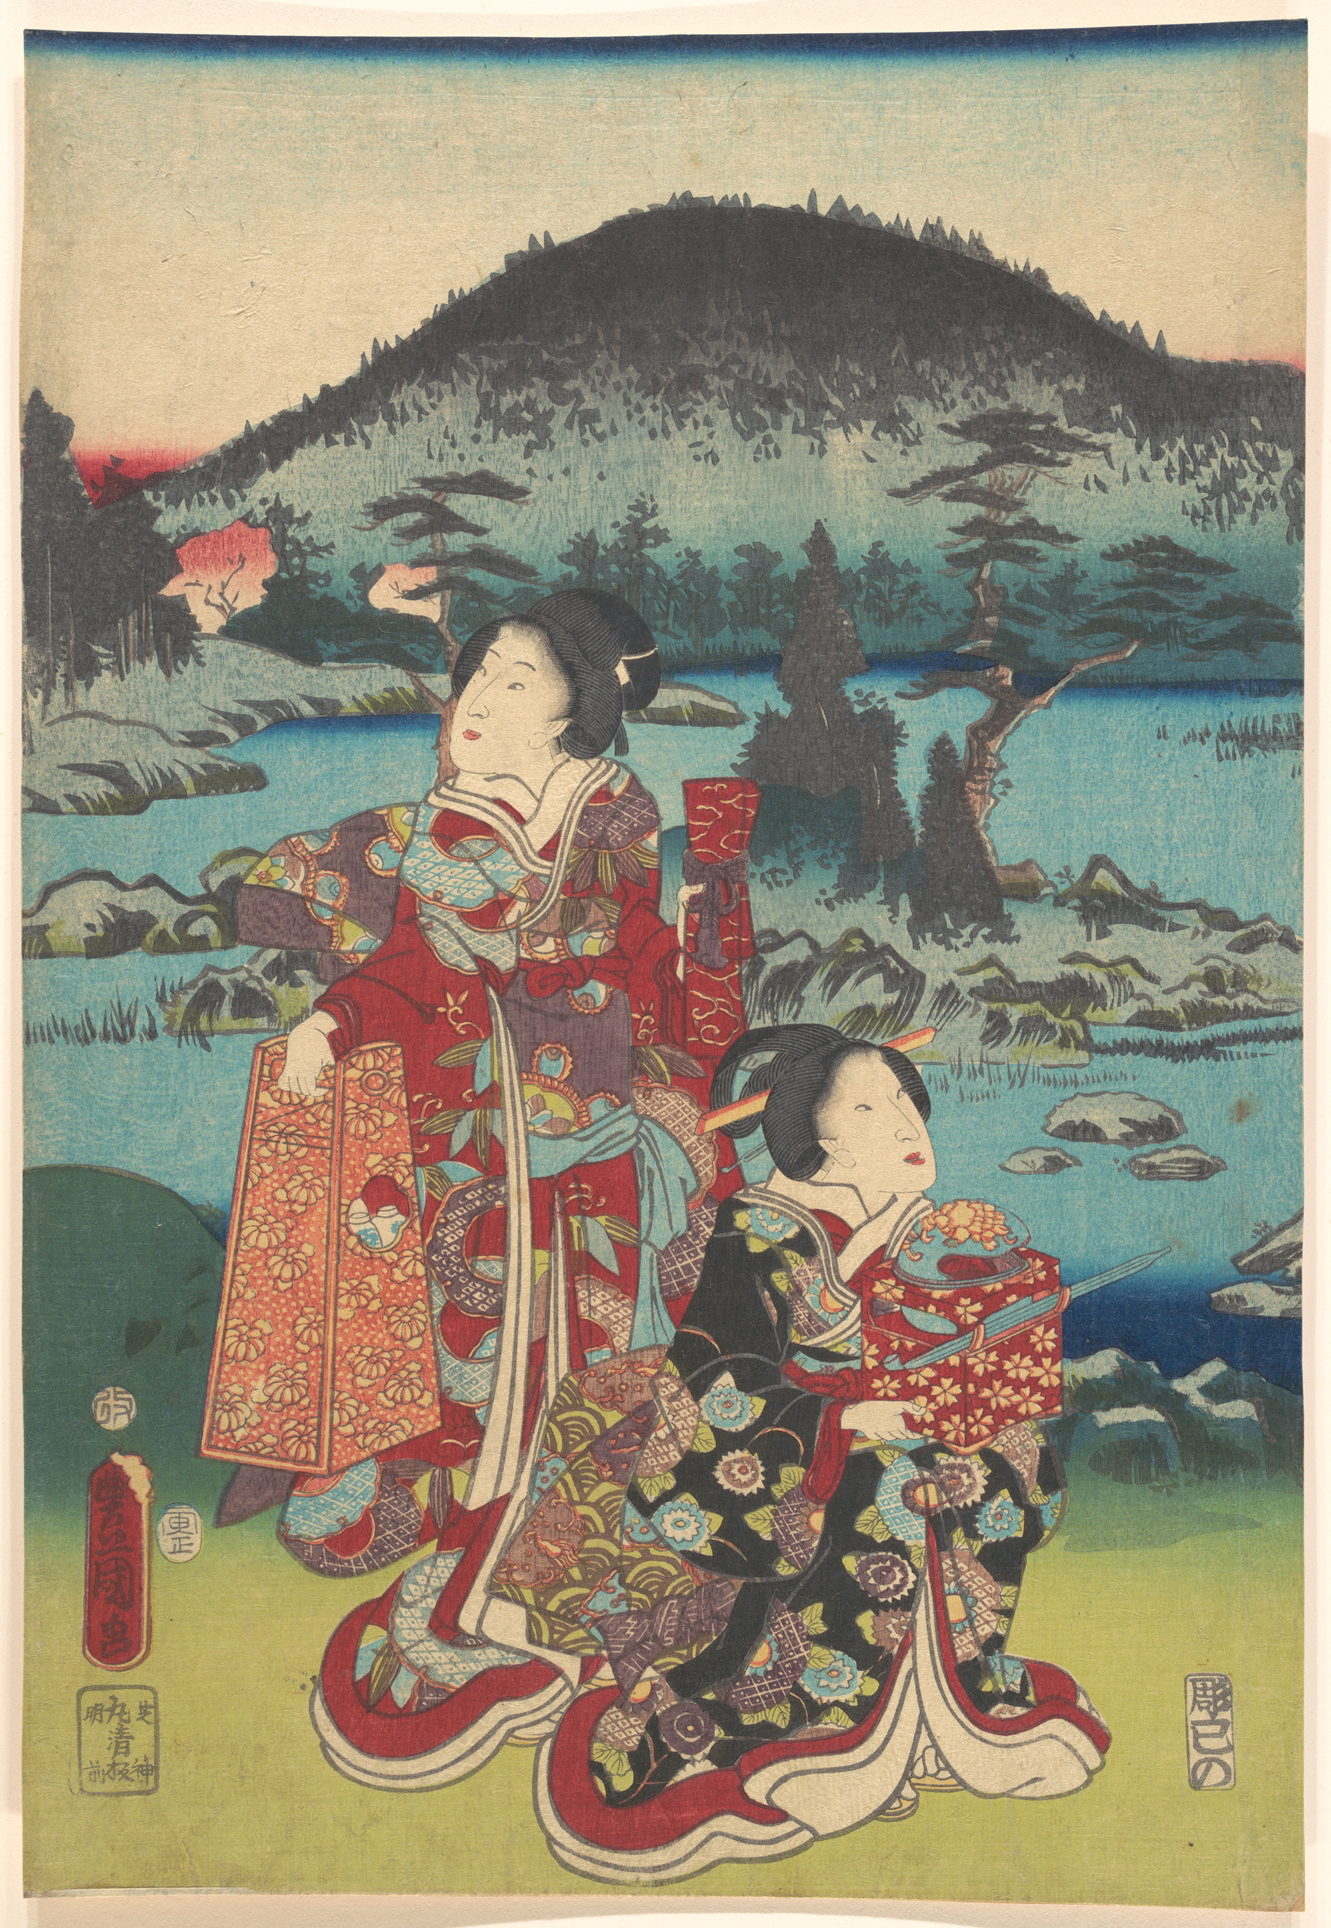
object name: print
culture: japanese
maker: utagawa kunisada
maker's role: artist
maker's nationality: japanese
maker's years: 1786-1864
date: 1786-1854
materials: ink, paper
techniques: woodblock print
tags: women